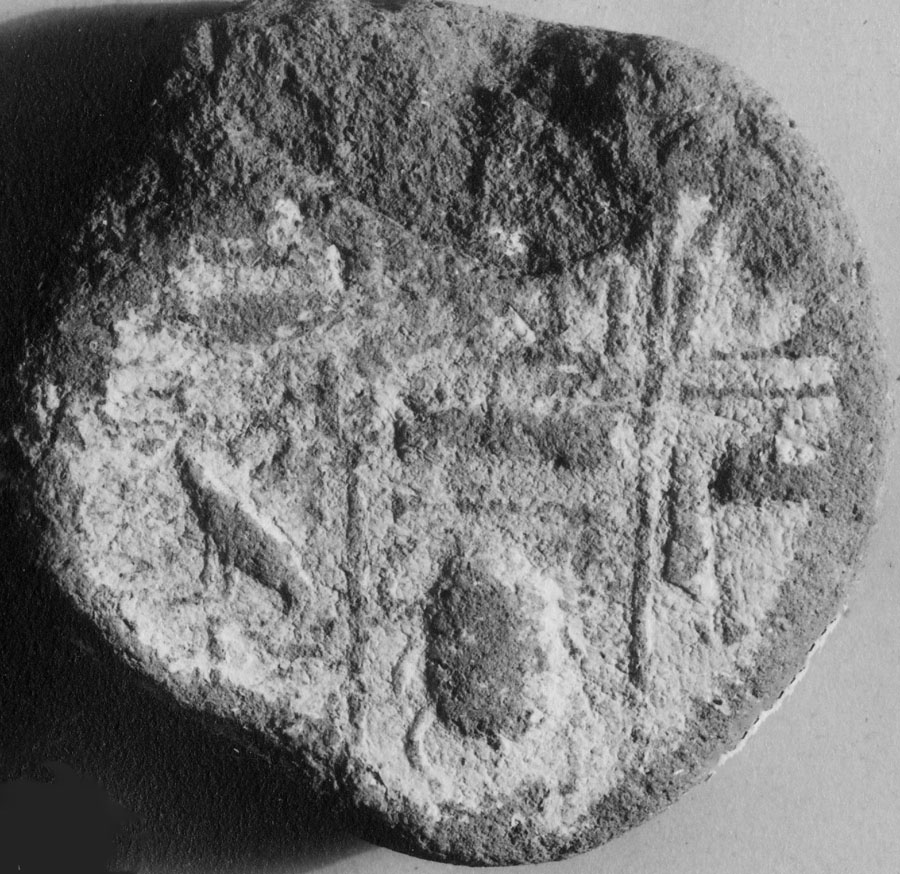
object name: cone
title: Funerary Cone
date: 1550-1295 BCE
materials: pottery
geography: egypt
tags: hieroglyphs